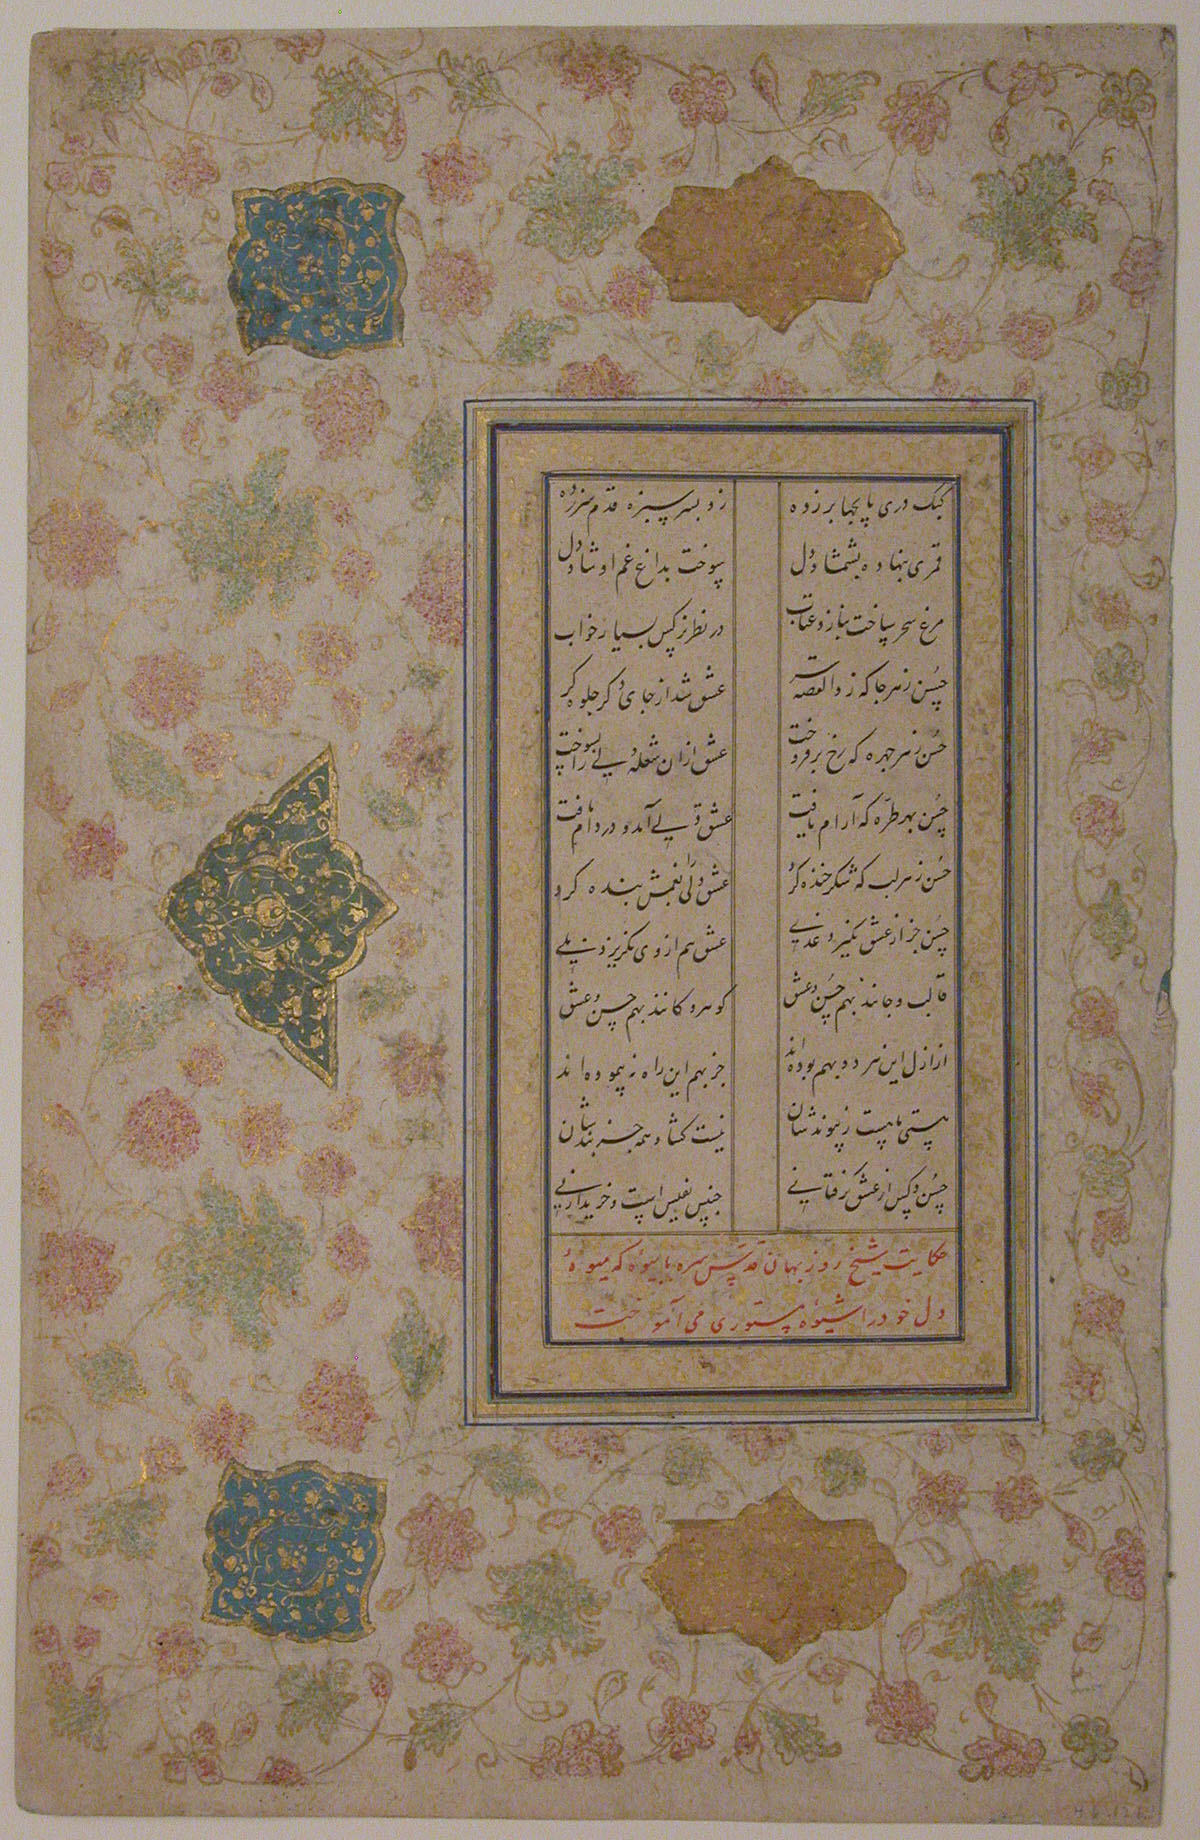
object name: folio from a non illustrated manuscript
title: Page of Calligraphy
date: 1501-1600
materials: gold, ink, paper, watercolor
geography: iran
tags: flowers,leaves